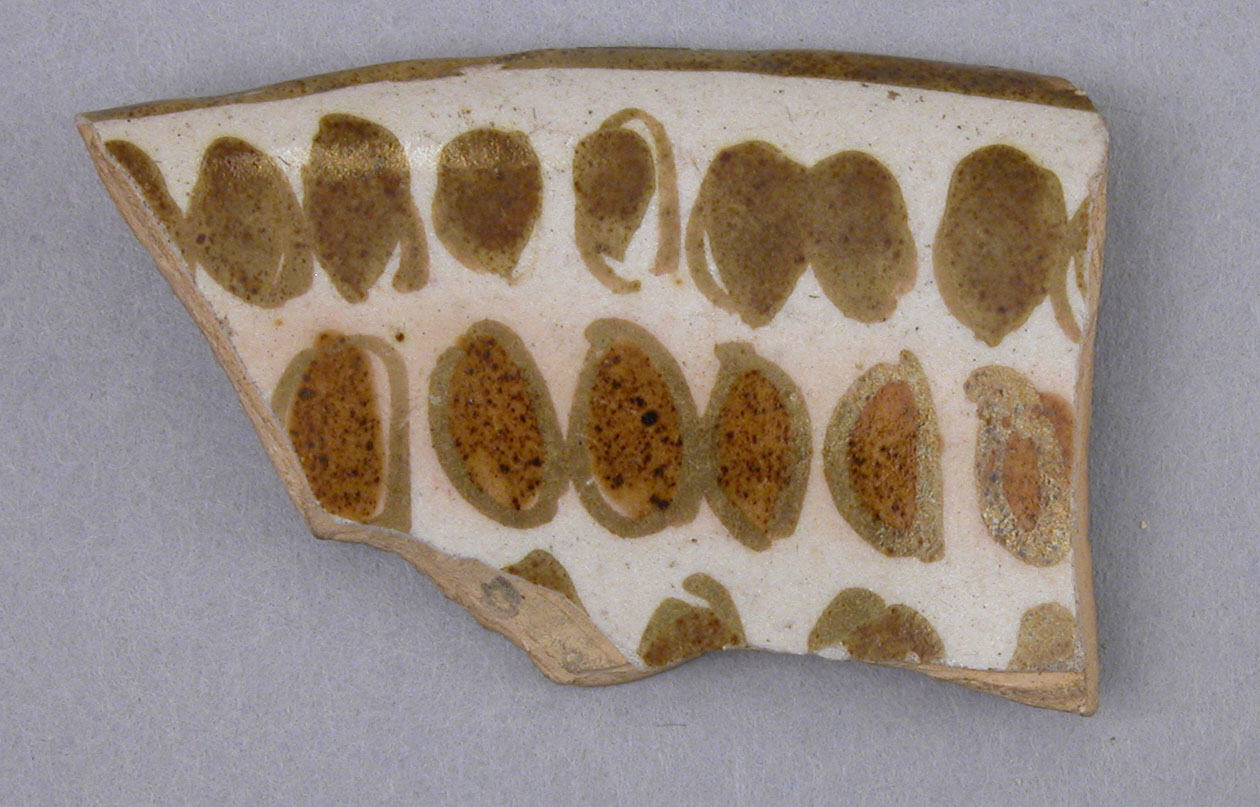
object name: fragment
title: Ceramic Fragment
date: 801-900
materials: earthenware, glaze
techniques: luster painting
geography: iraq